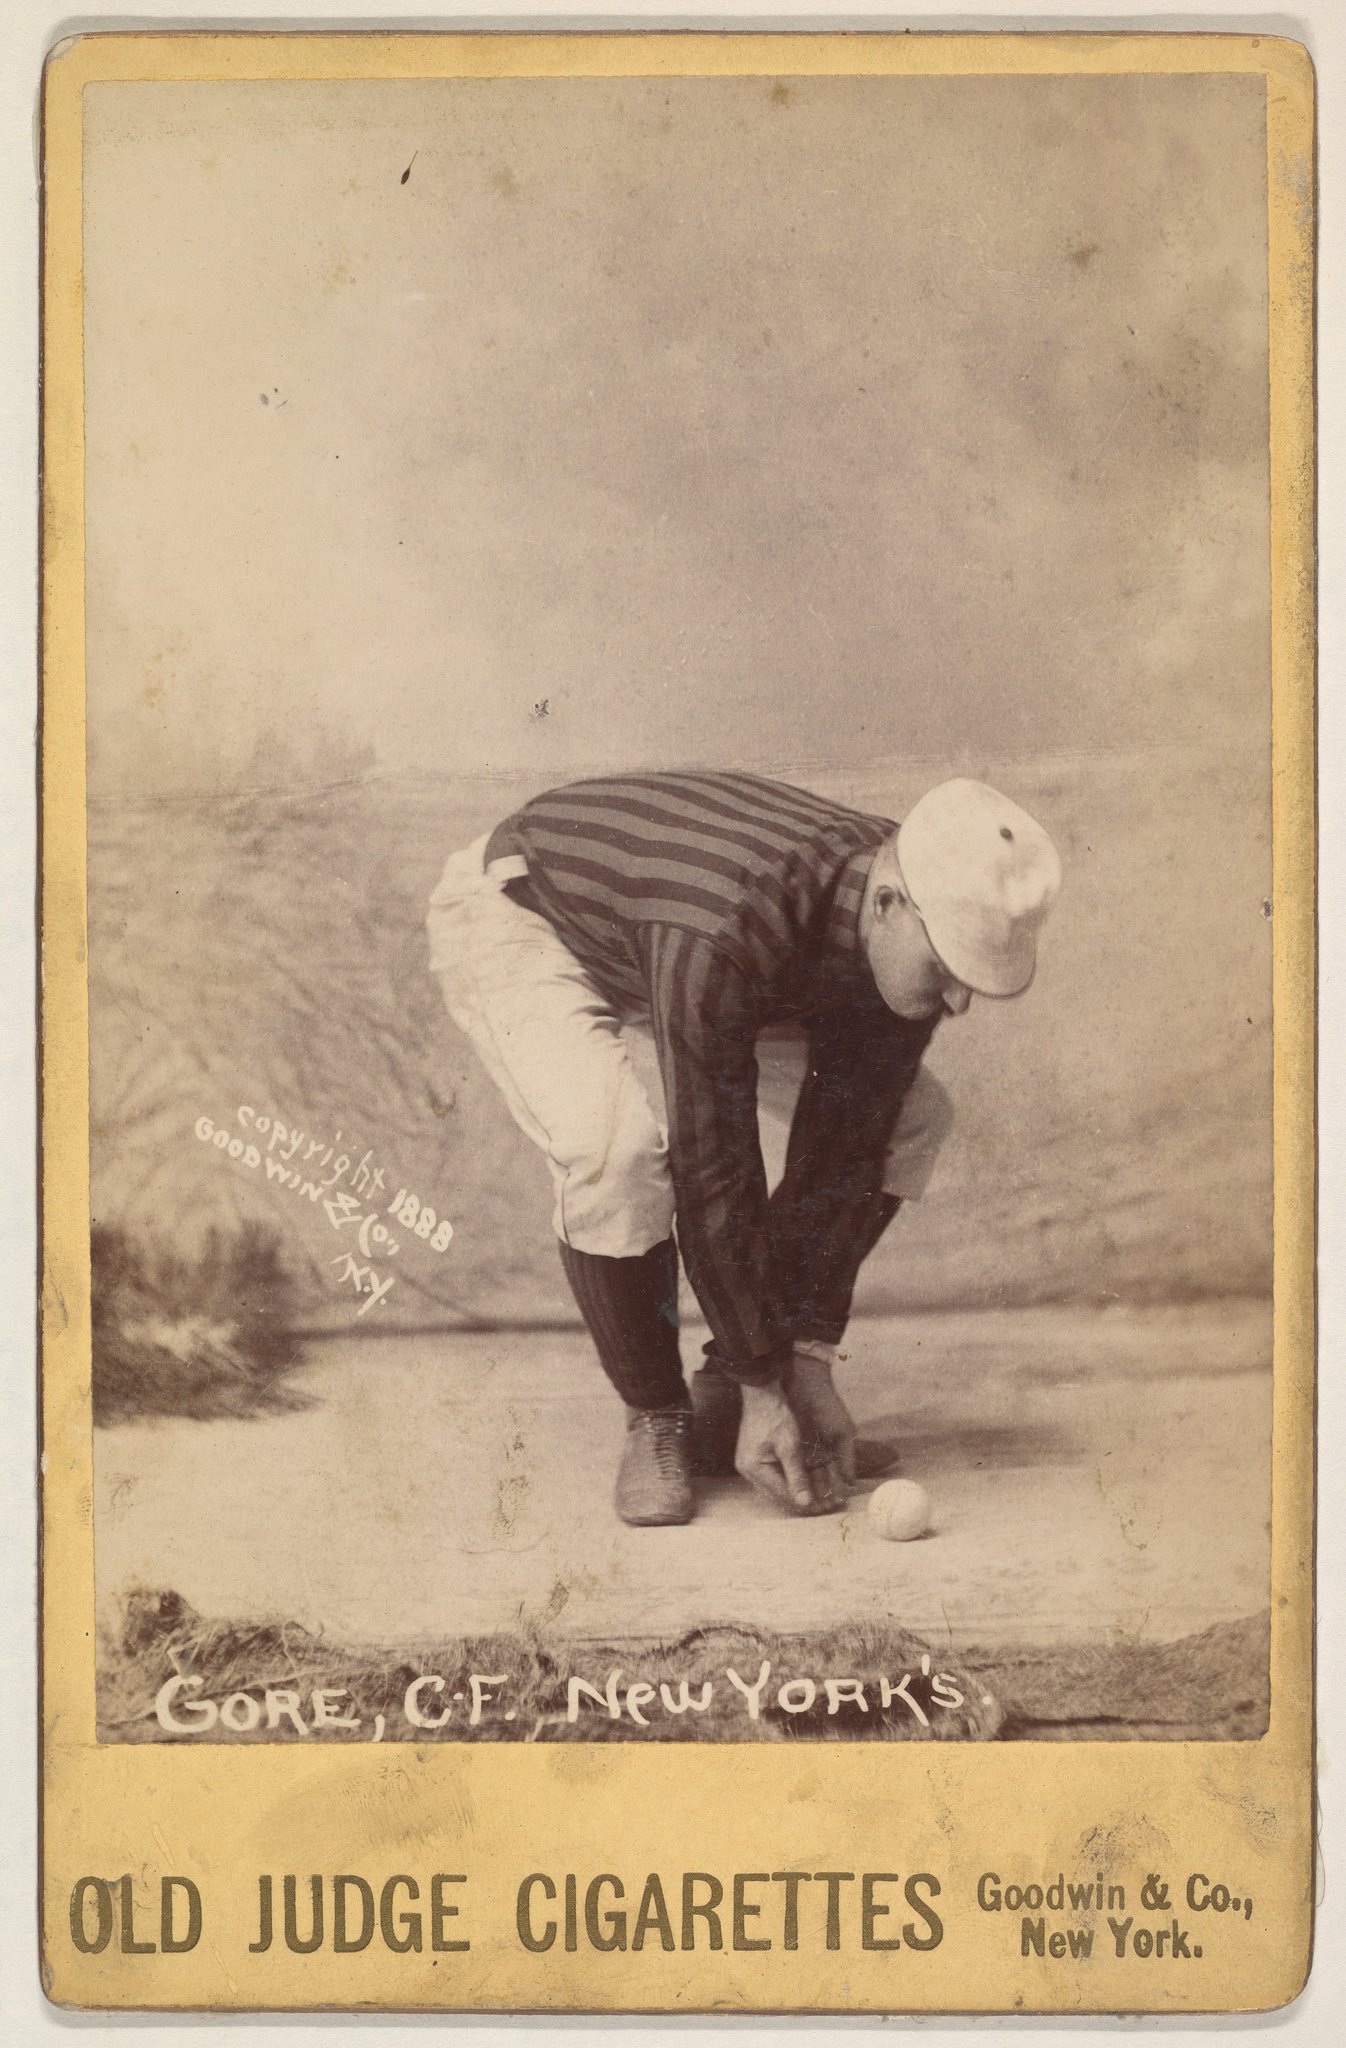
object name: baseball card, photograph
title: Gore, Center Field, New York, from the series Old Judge Cigarettes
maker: goodwin & company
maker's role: publisher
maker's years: 1850-1950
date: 1888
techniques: albumen silver print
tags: men,portraits,baseball,athletes